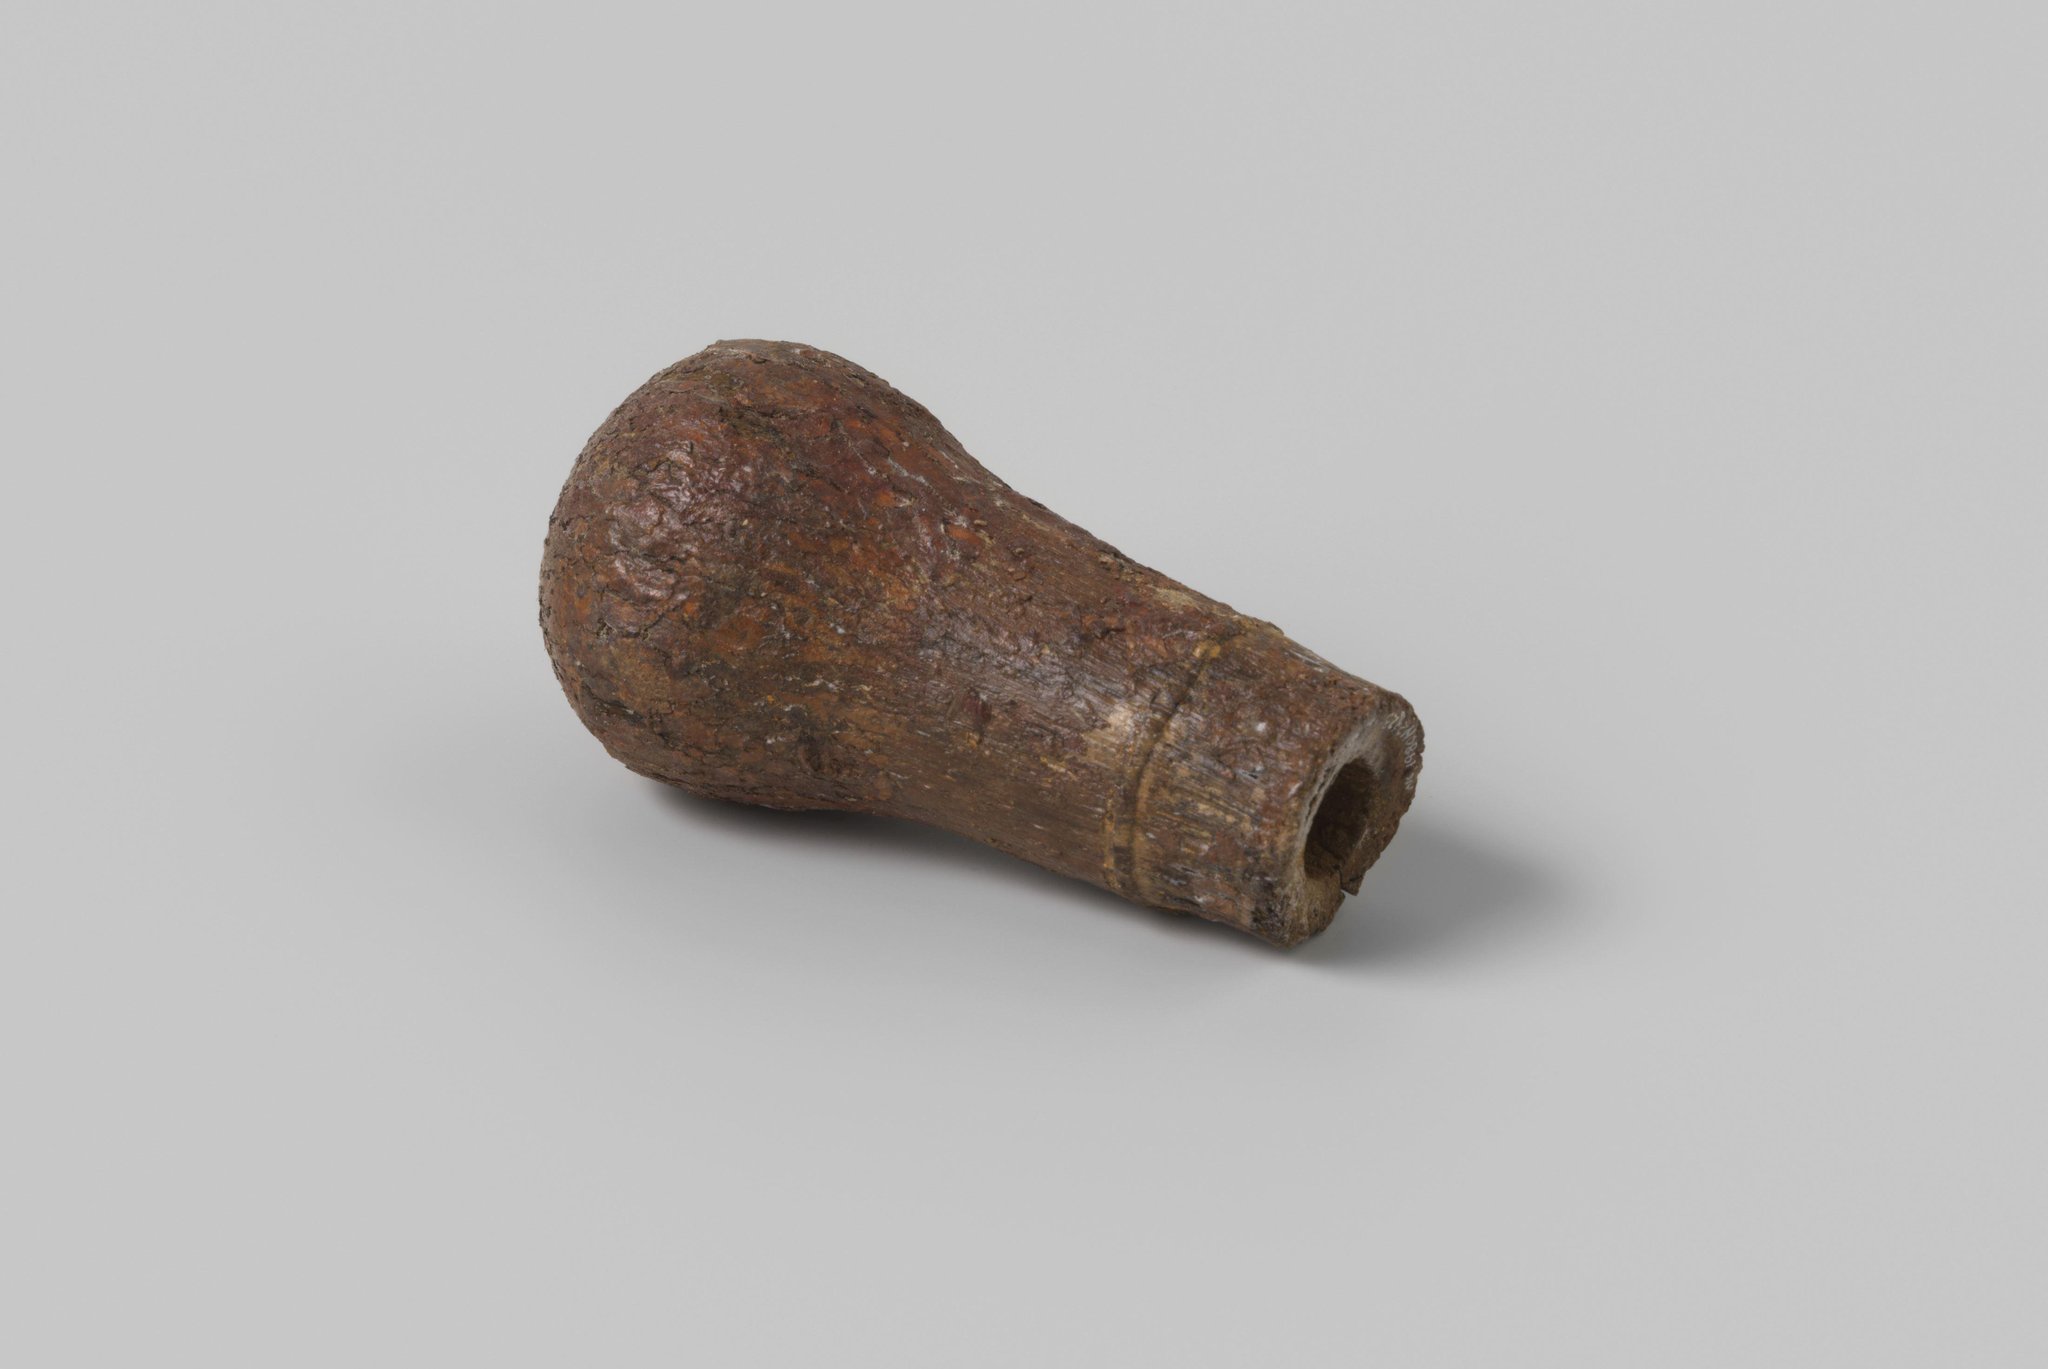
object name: chisel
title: Handvat van een priem of een beitel uit het wrak van de Oost-Indiëvaarder Hollandia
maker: Anonymous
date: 1700-1743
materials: wood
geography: netherlands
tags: verenigde oostindische compagnie, hollandia (schip), annet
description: Tools and instruments, various tools, awl/chisel handle; swollen rounded upper end, tapering towards straight lower end, circular in section, with traces of metal ferrule, circular tang cavity.